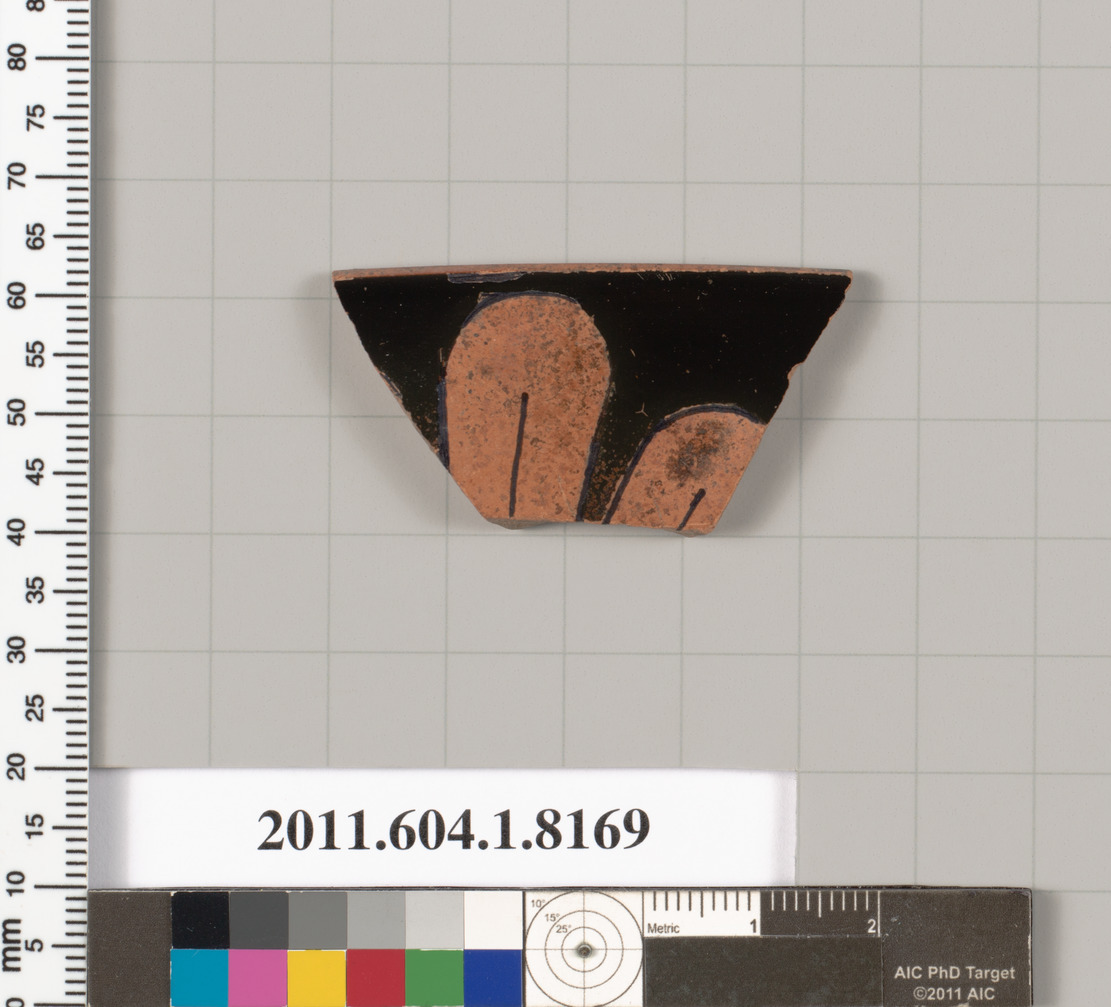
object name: kylix fragment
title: Terracotta rim fragment of a kylix (drinking cup)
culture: greek, attic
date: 520-510 BCE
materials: terracotta